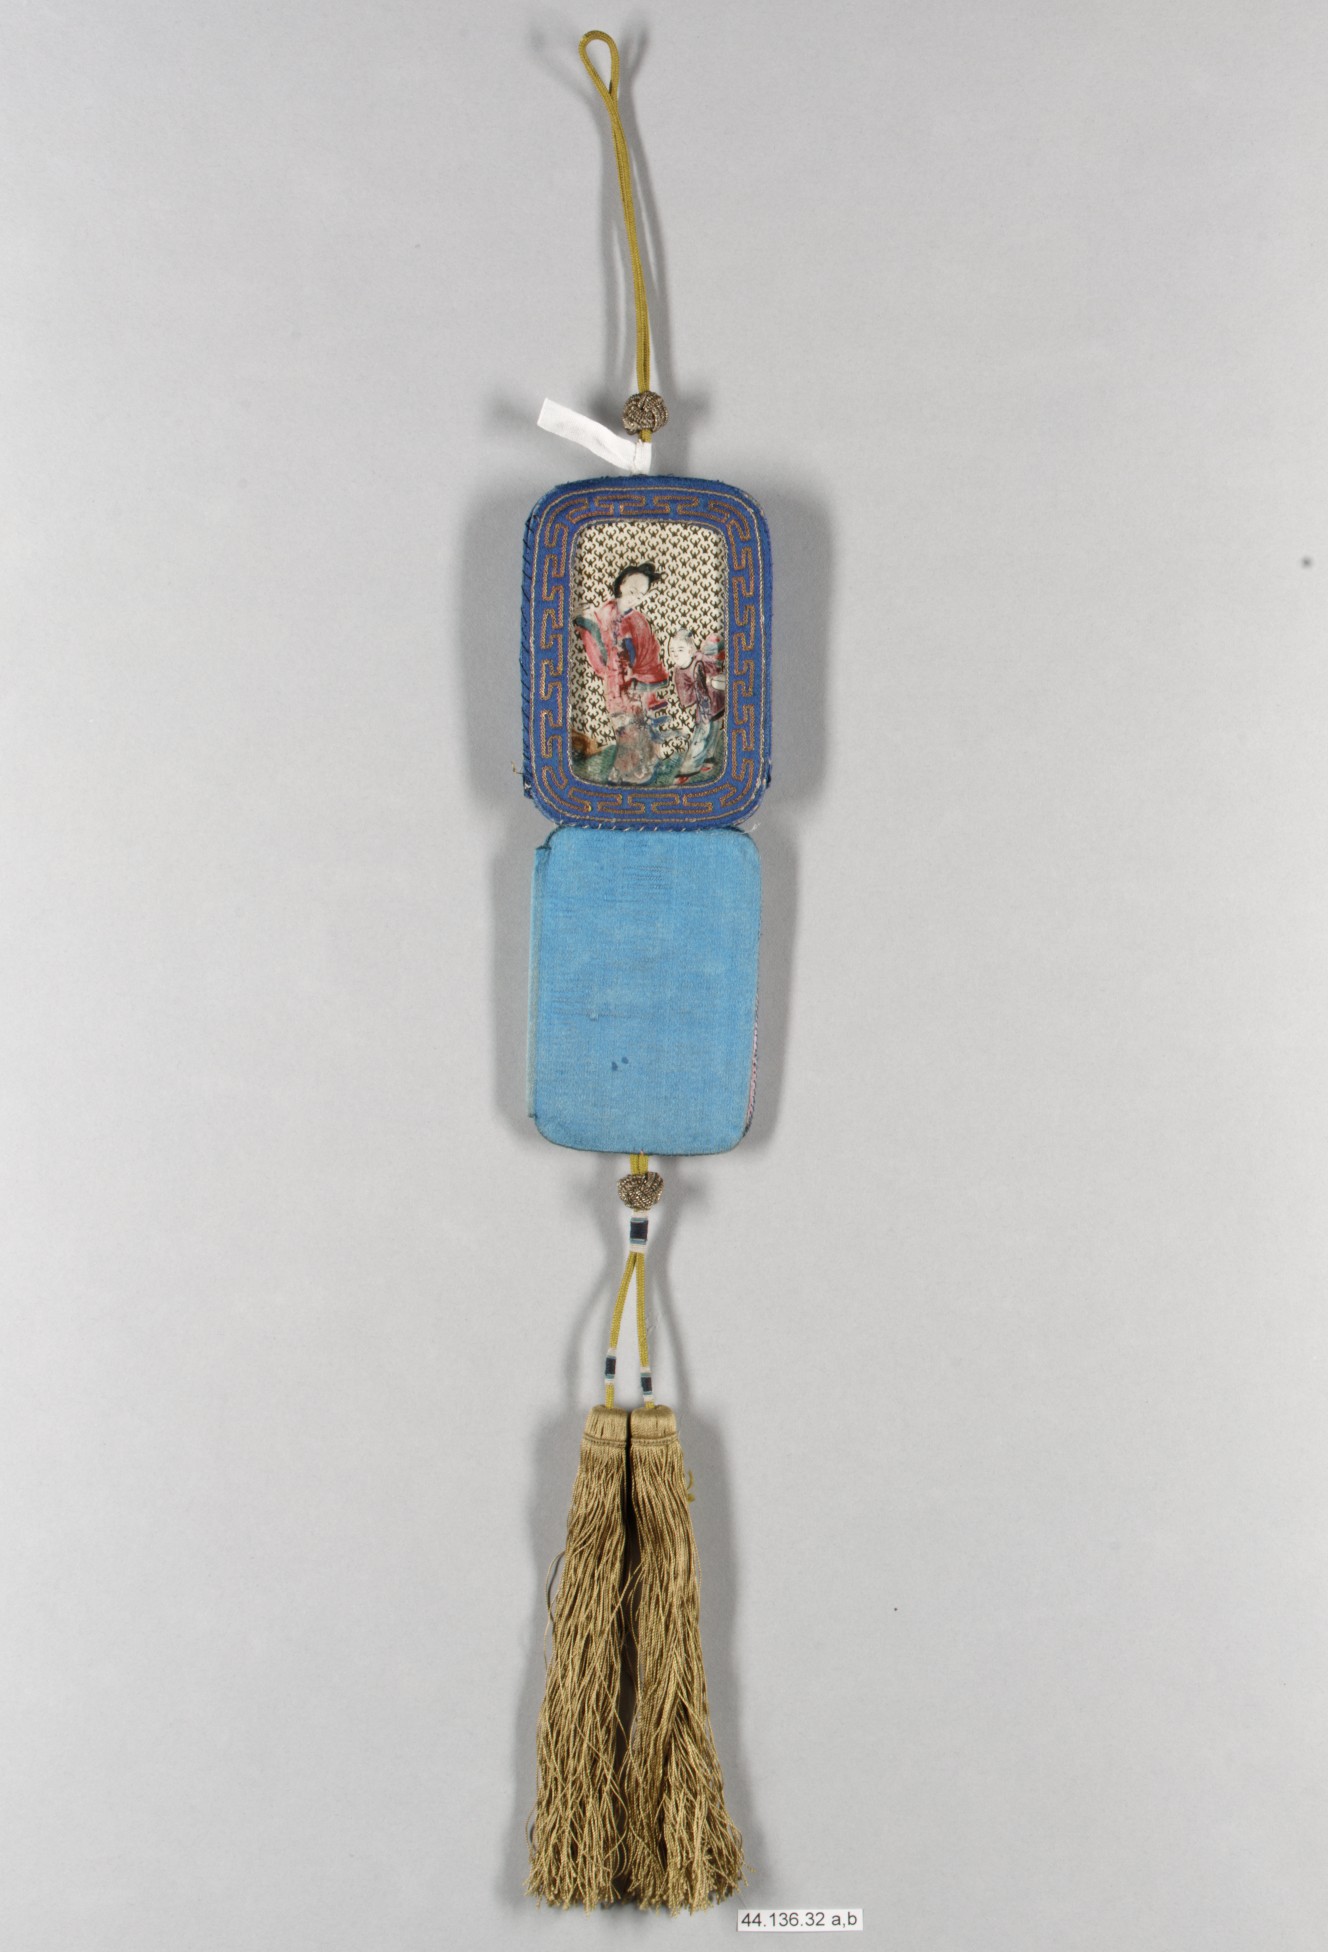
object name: needle case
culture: chinese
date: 1701-1900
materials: ivory, metal thread, silk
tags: boys,women